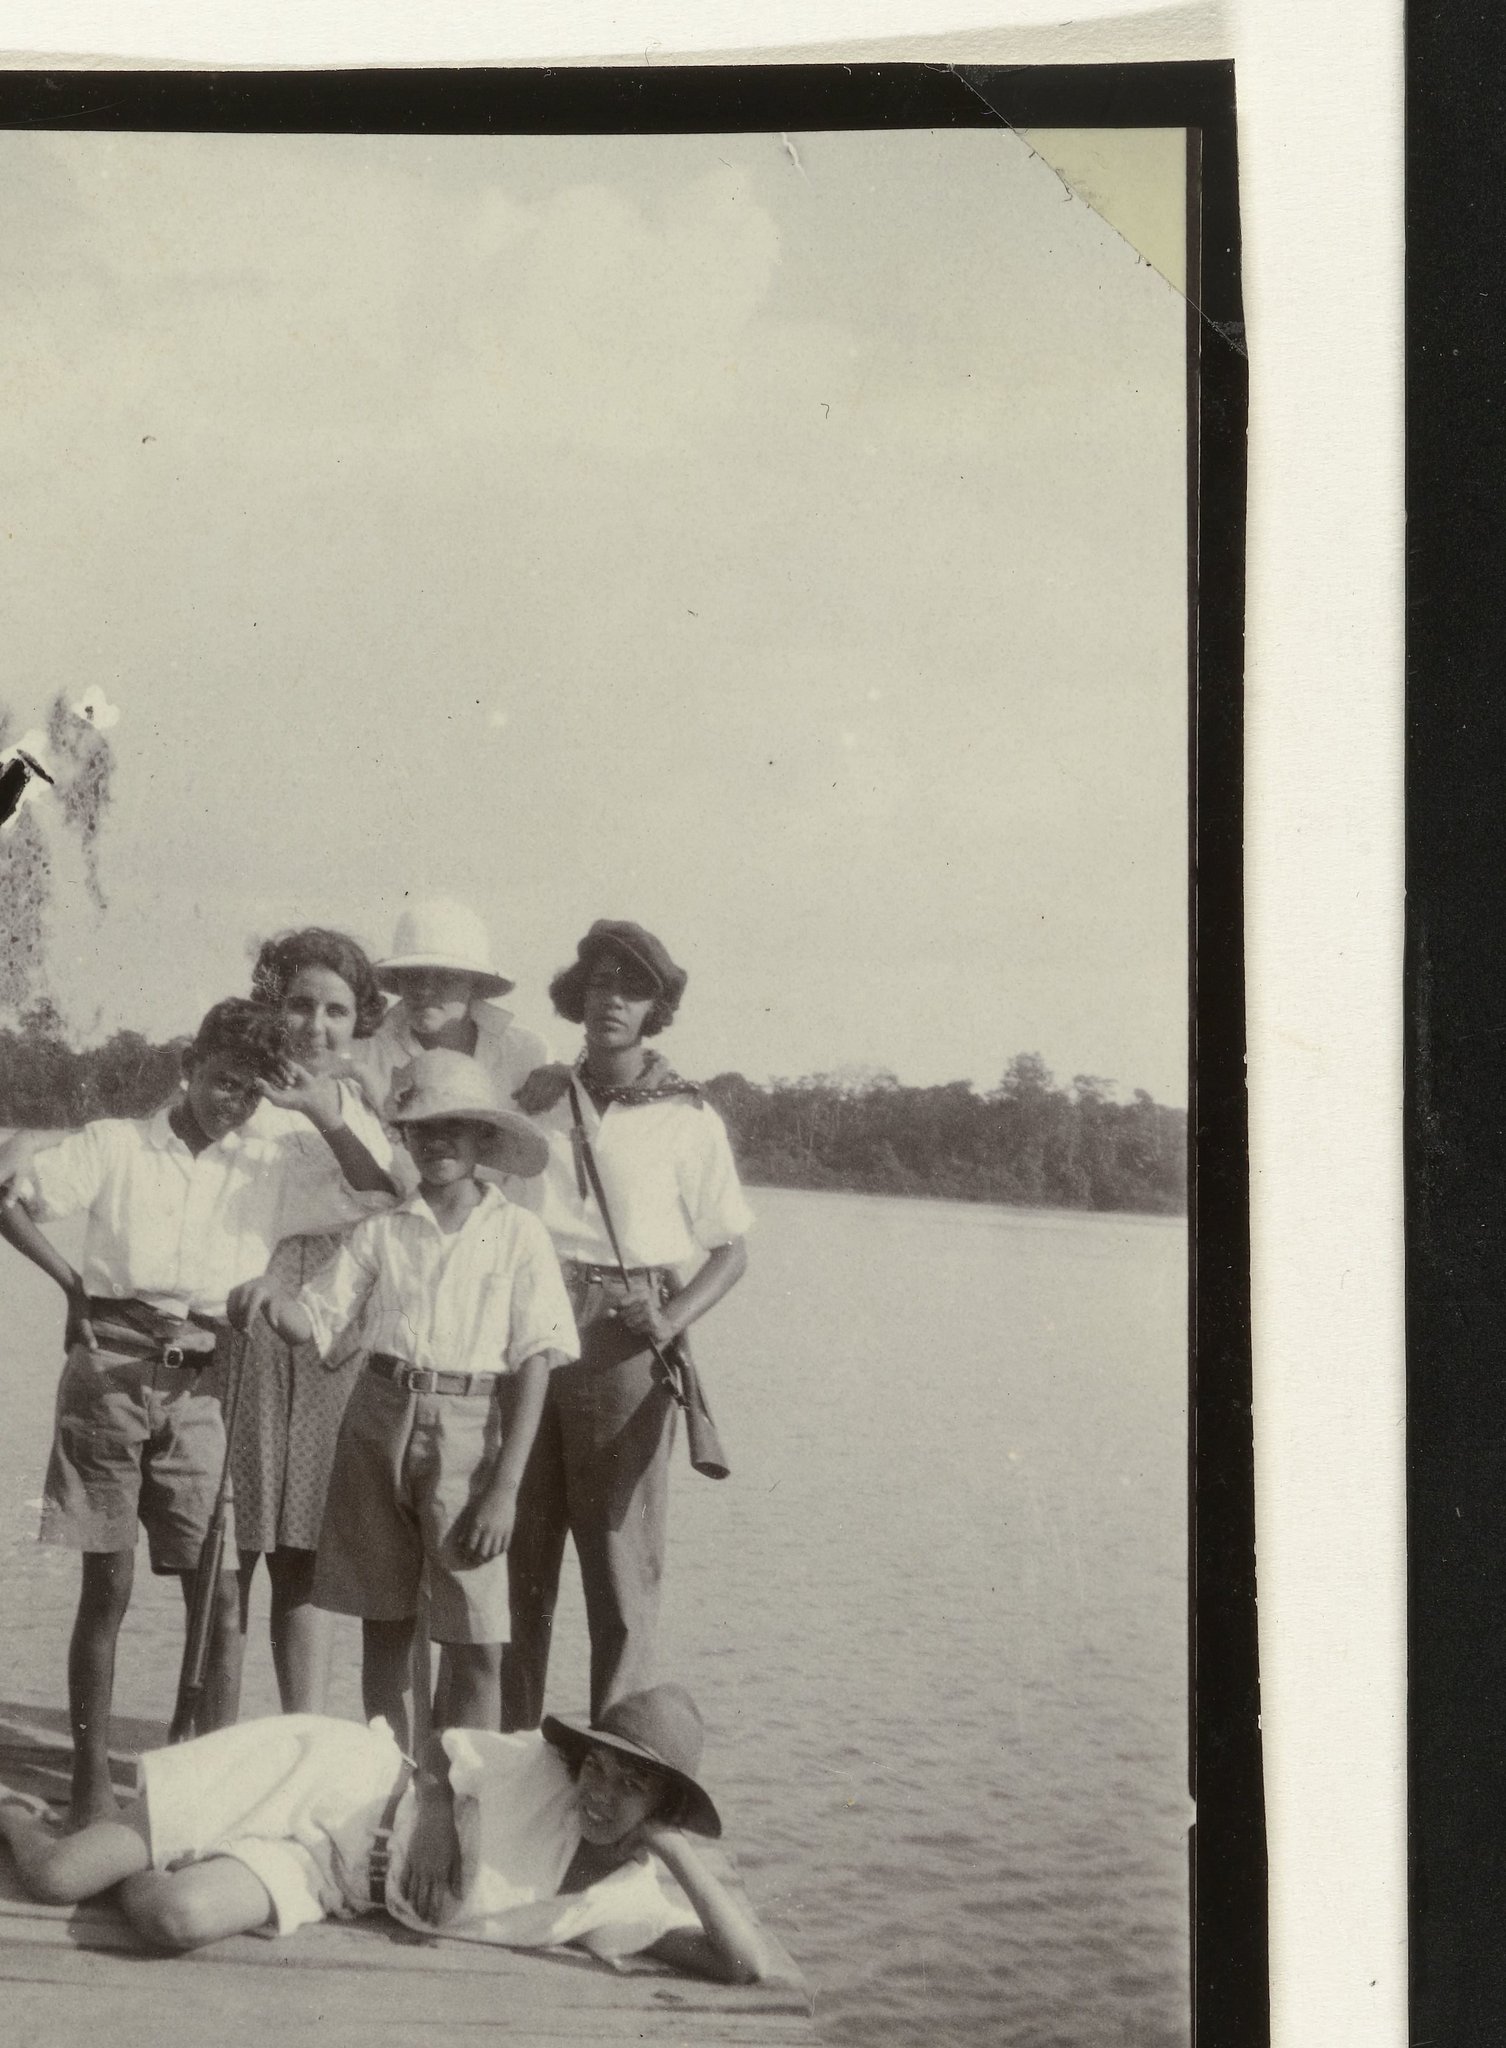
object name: photograph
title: Kinderen op de steiger van plantage Accaribo, Suriname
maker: theodoor brouwers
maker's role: amateurfotograaf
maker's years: 1874-1932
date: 1910-1930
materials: photographic support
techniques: photography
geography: suriname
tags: amsterdam, theodoor brouwers, suriname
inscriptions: inscription: ‘Accaribo okt. 1930’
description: In de periode 1911-1932 woonde op plantage Accaribo in Suriname de familie Brouwers van wie de foto's afkomstig zijn. Rond 1910 vond Theodoor Brouwers werk op plantage Accaribo. In 1929 werd hij eigenaar van de plantage.